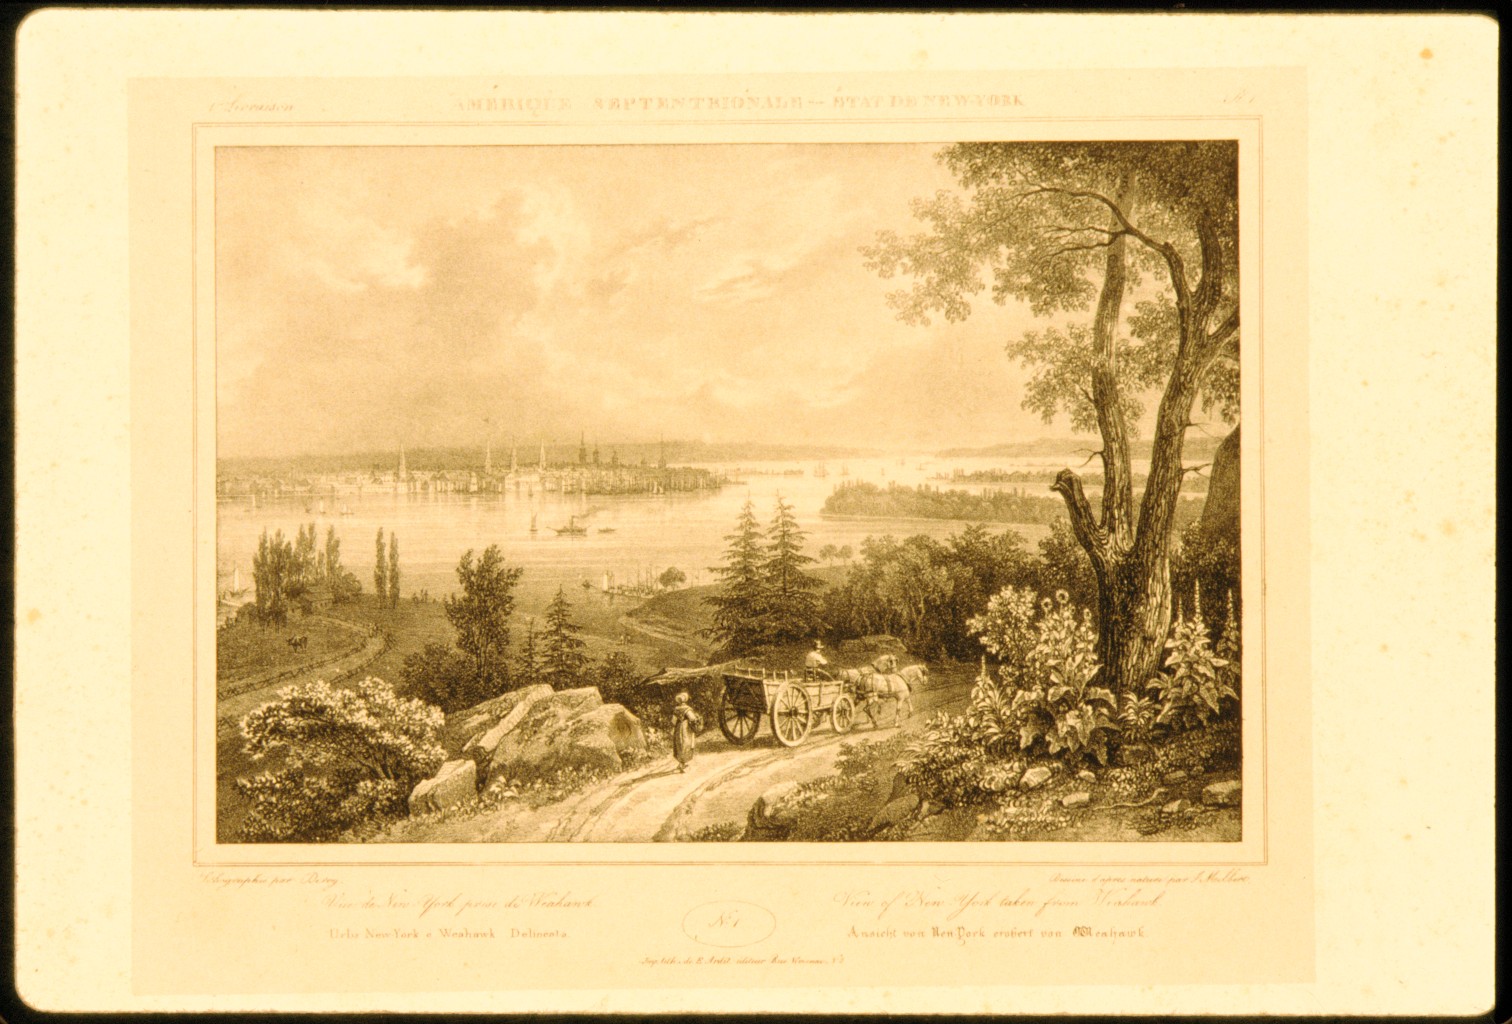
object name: print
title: View of New York taken from Weehawken (Amérique Septentrionale - État de New-York)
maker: isidore-laurent deroy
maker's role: artist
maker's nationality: french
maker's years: 1797-1886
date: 1826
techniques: lithograph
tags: roads,horses,carts,new york city